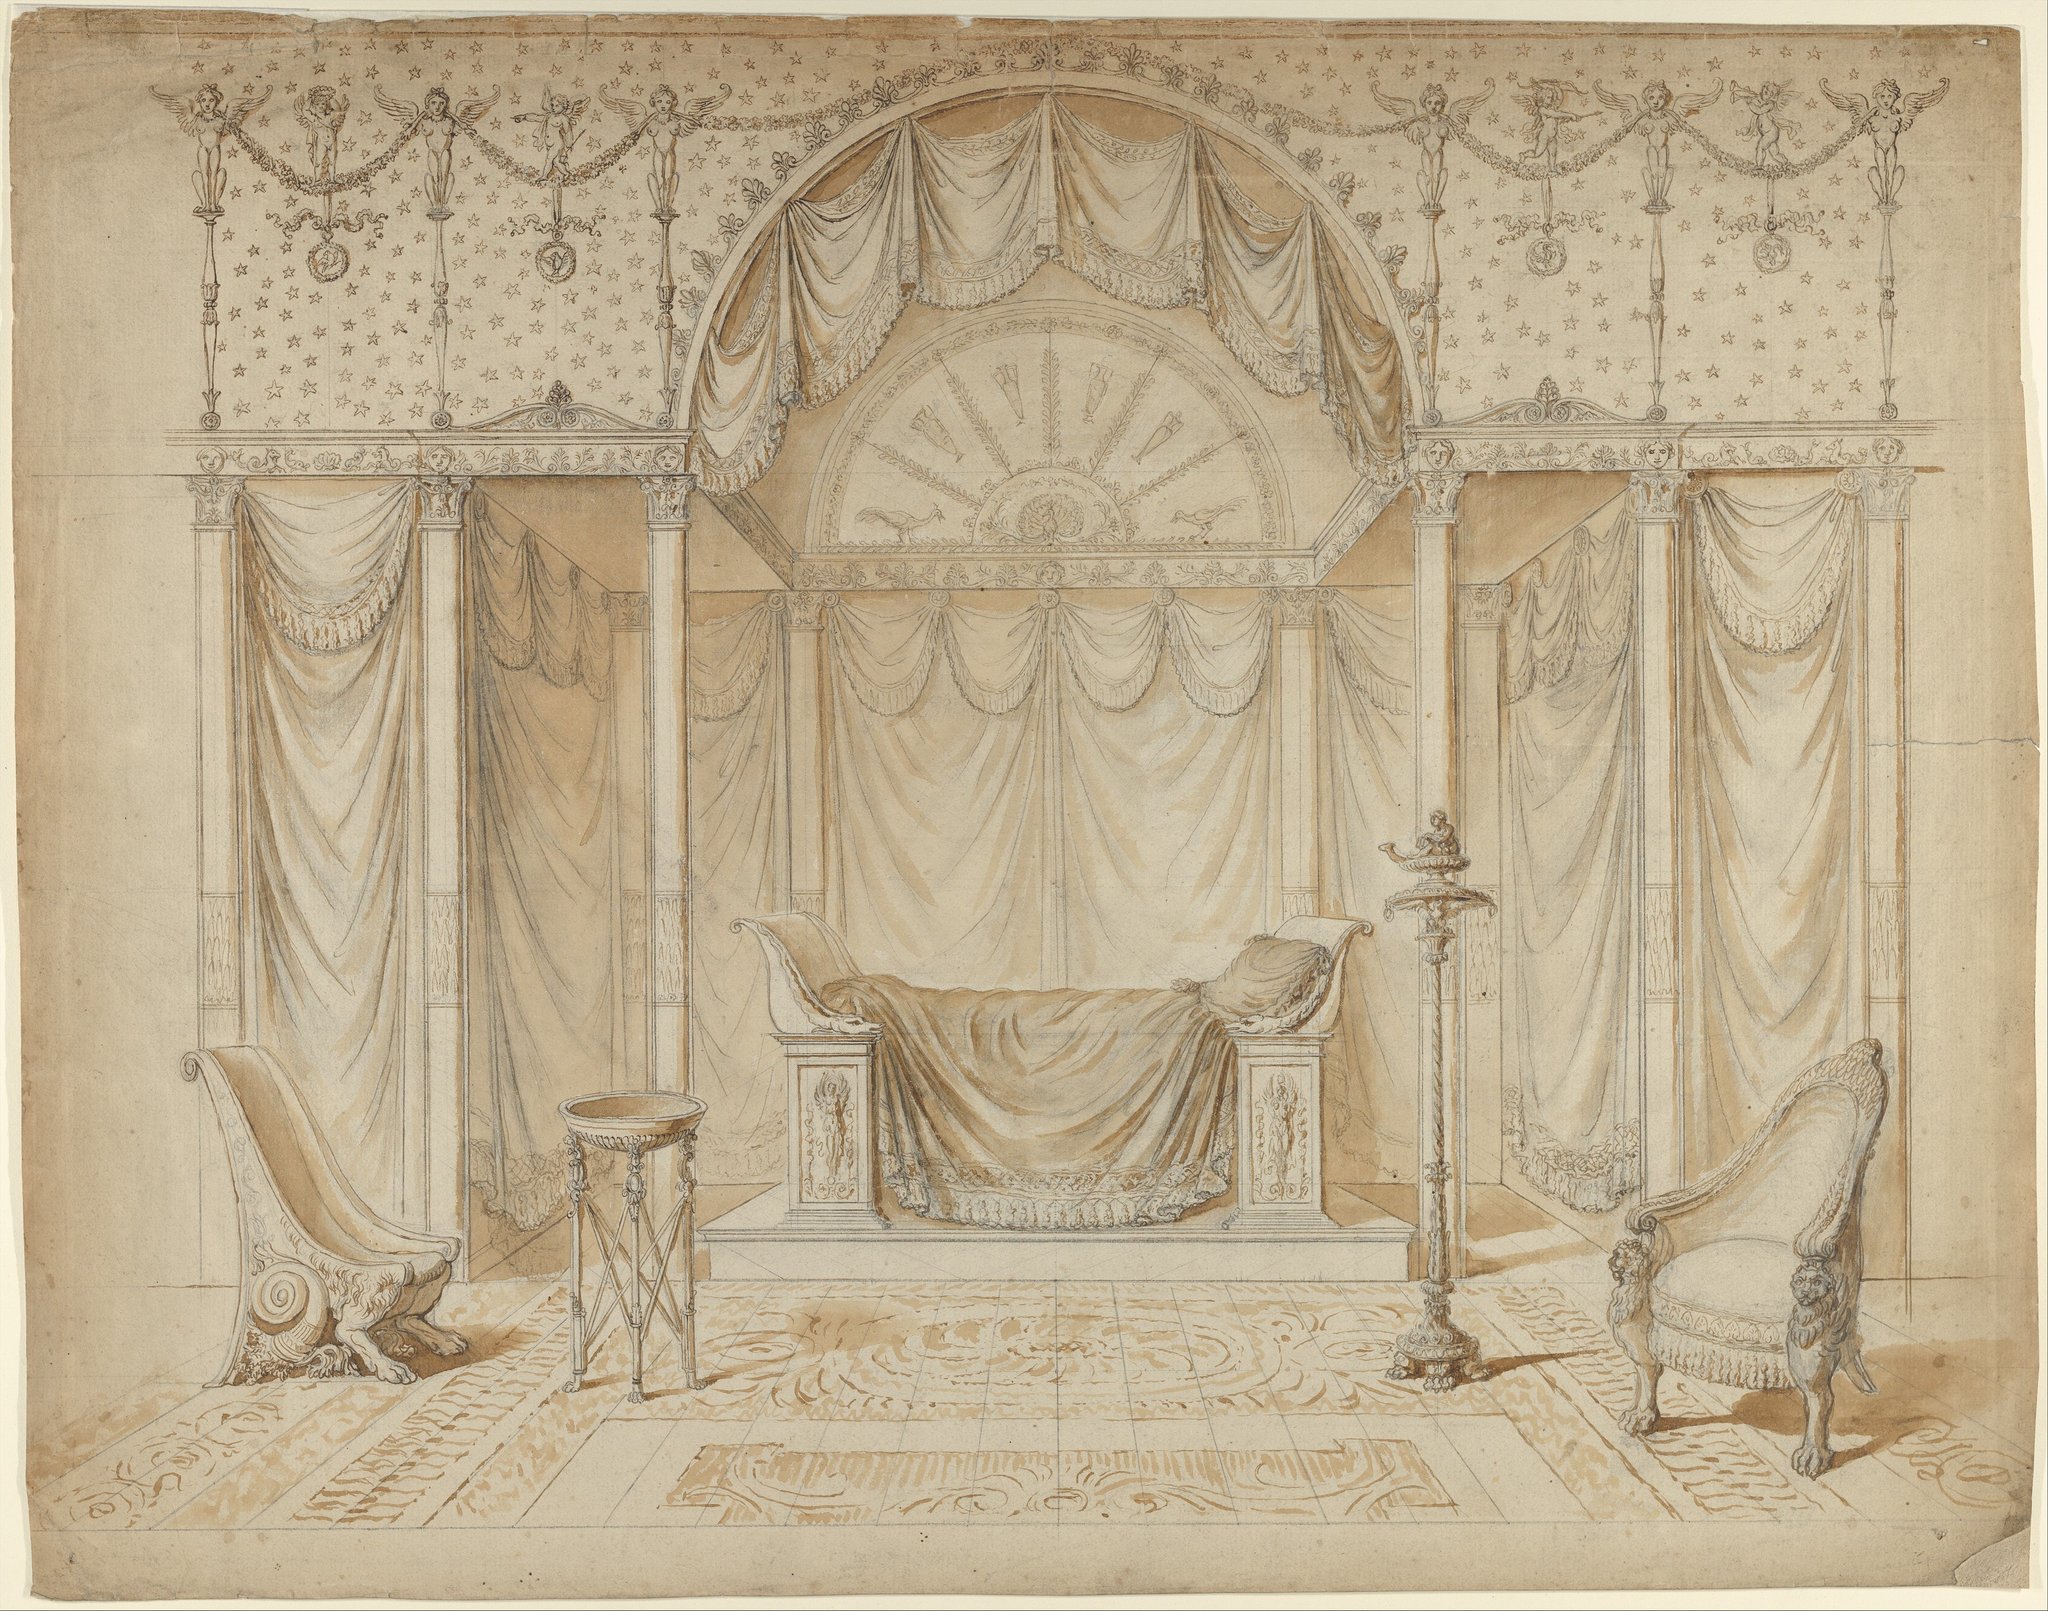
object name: drawing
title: Design for a Bed Alcove in Empire Style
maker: anonymous, french, 19th century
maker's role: artist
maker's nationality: french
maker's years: 1800-1900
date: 1805-1810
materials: graphite, ink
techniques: brush, pen, wash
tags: bedrooms,beds,chairs